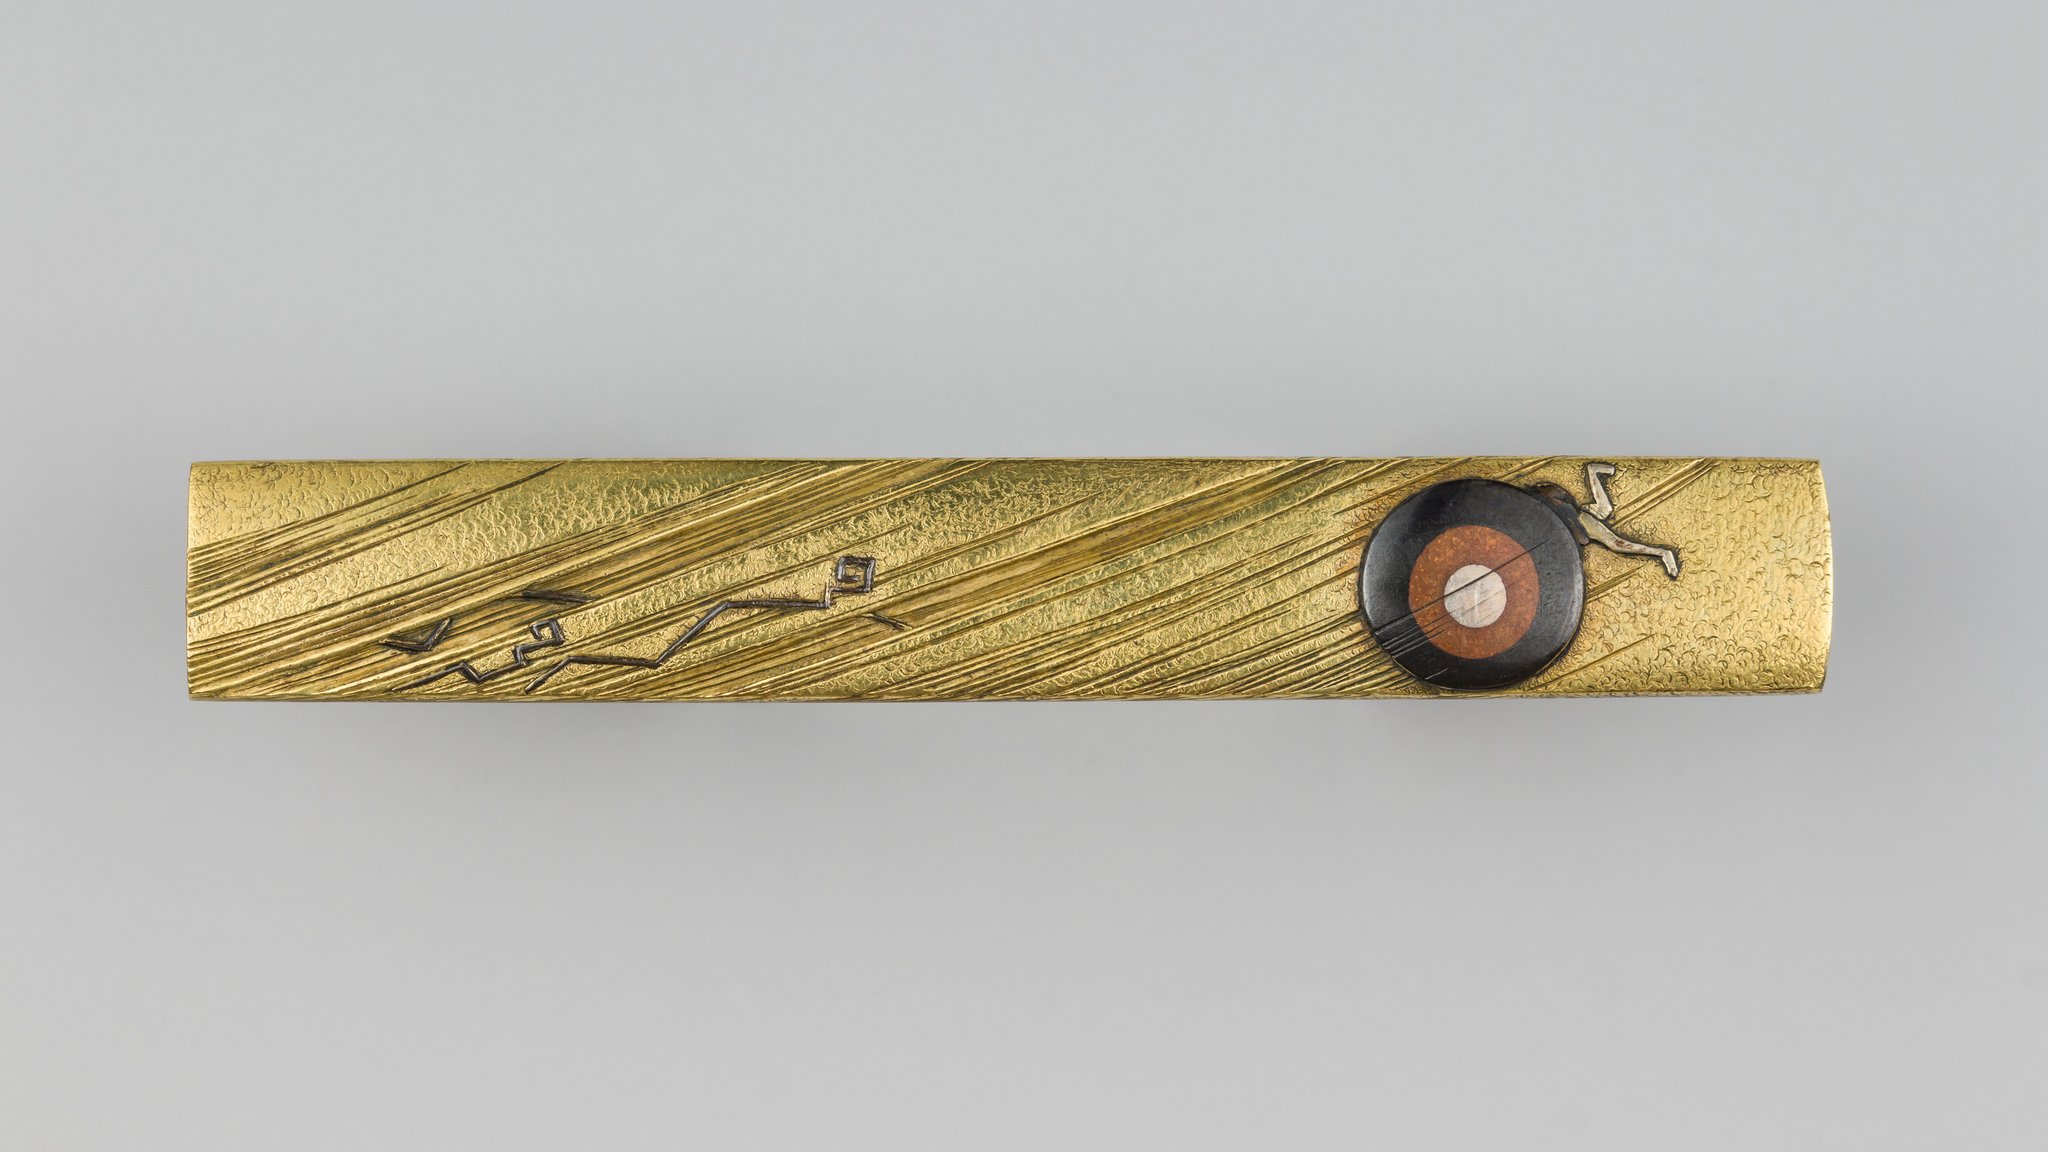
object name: knife handle kozuka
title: Knife Handle (Kozuka)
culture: japanese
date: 1767-1800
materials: copper, gold alloy, silver alloy, gold, silver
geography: japan